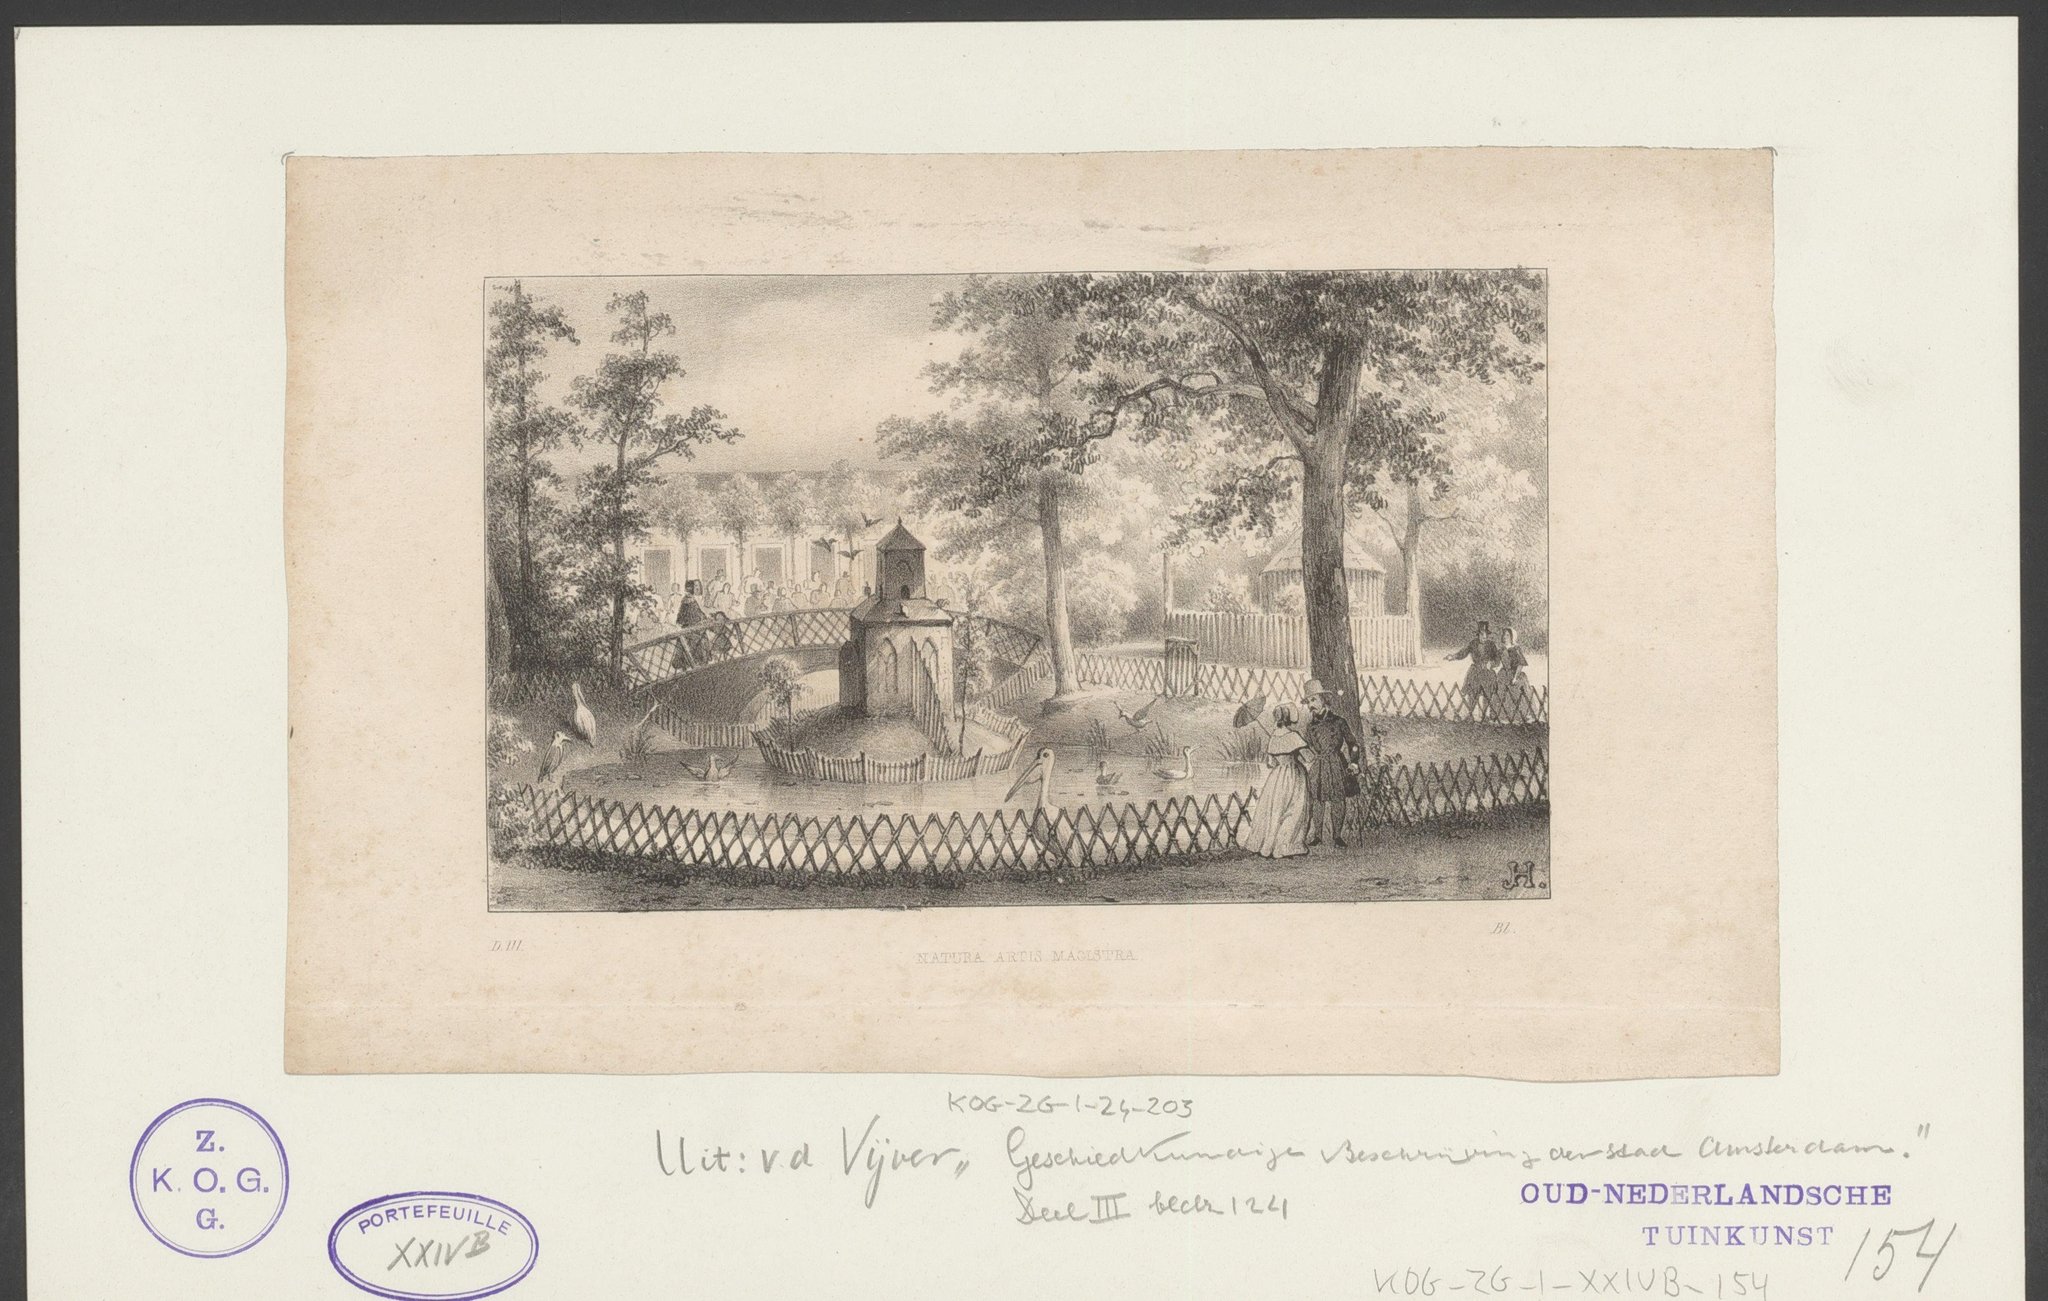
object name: print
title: Natura Artis Magistra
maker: johannes hilverdink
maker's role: draughtsman, painter, print maker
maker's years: 1813-1902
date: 1846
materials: paper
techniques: blind stamped, lithograph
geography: amsterdam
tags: water-birds: pelican, zoo (as place of recreation)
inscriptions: stamp, stamp, collector's mark: Lugt 1641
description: De tuin van Artis met eendenvijver en eilandje met eendenhuis. Pelikaan op de voorgrond. Rechtsonder genummerd: D. III. Onderwerpsrubrieken binnen de Atlas Zeden en Gewoonten: Zeden en Gewoonten in Engeren Zin, De Woning, Oude Nederlandsche Tuinkunst. Koepels en tuinmeubelen.